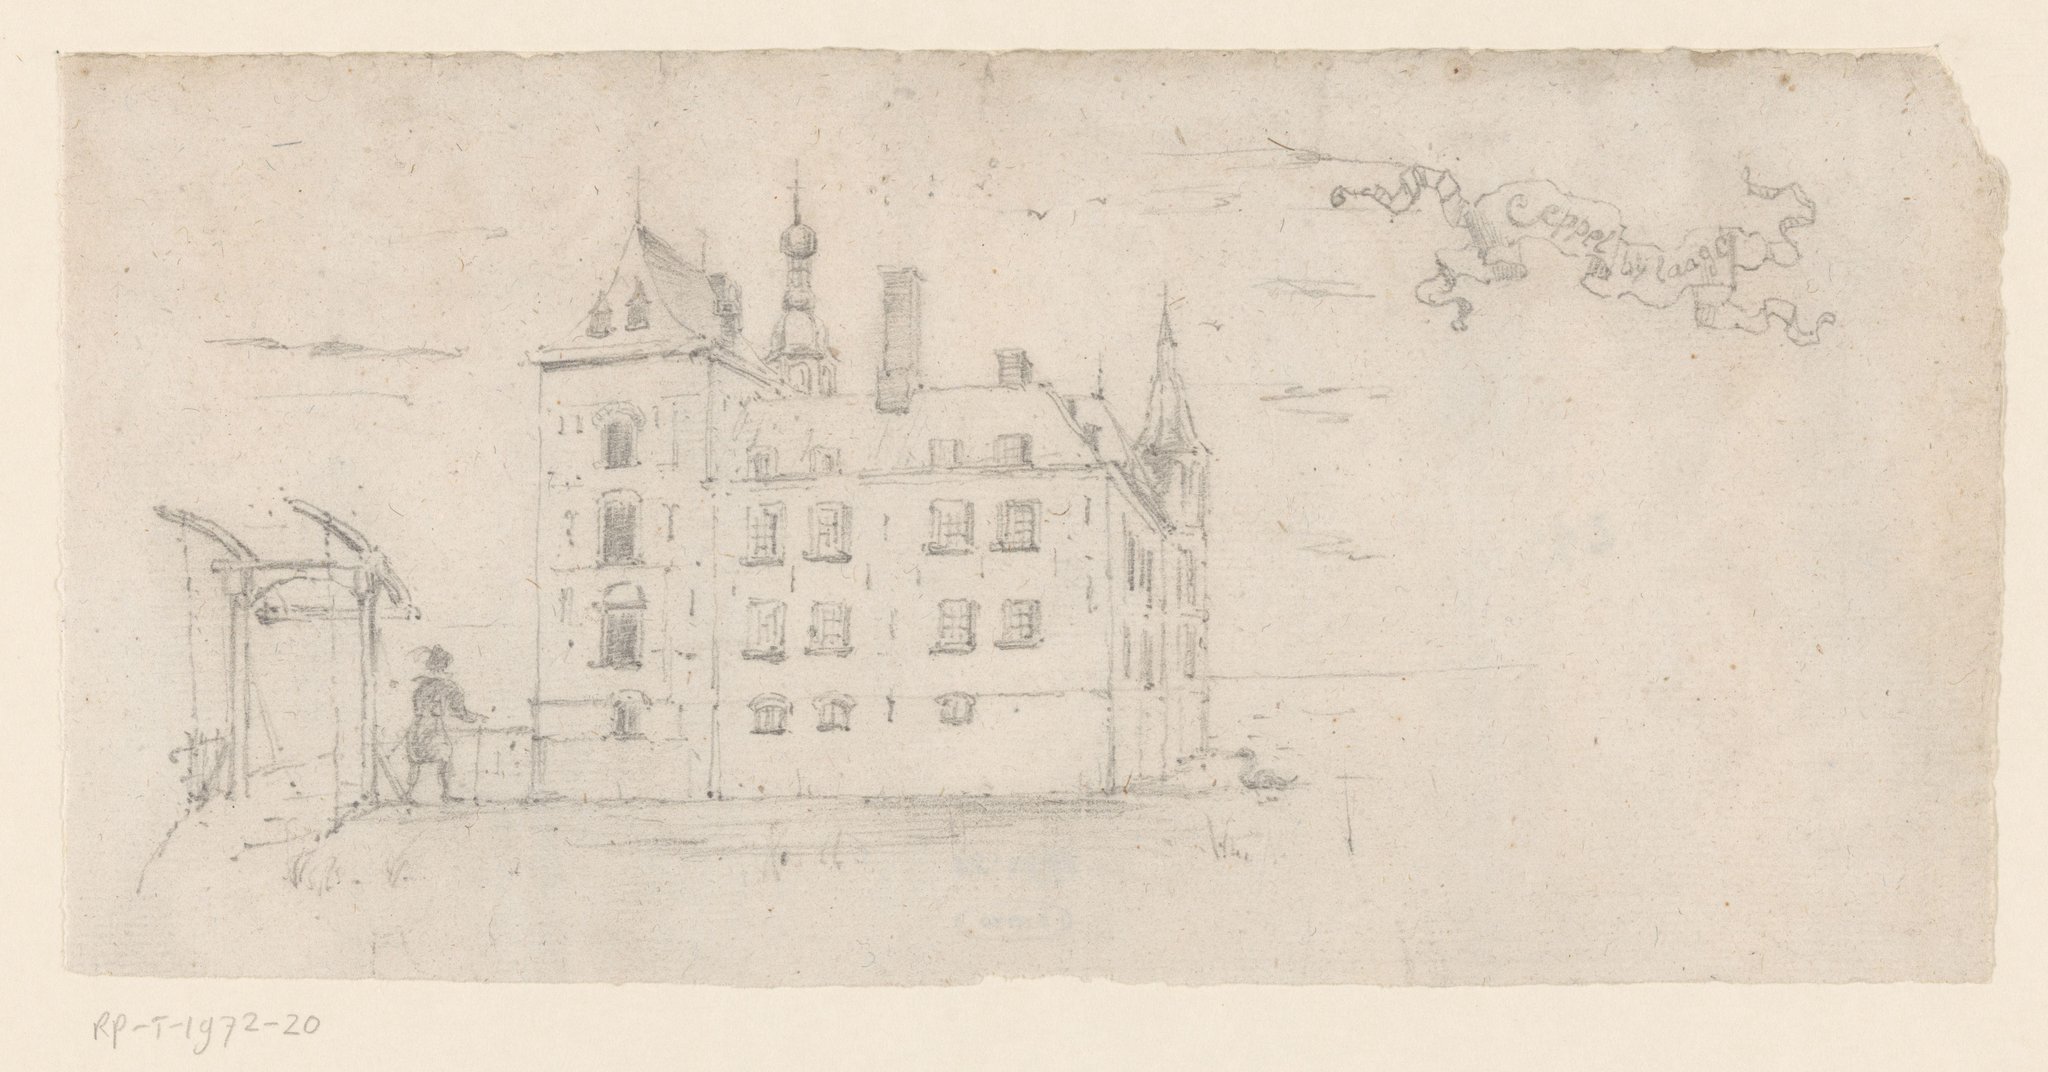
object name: drawing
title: Gezicht op Kasteel Keppel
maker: Anonymous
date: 1800-1850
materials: paper, pencil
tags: castle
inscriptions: collector's mark: Lugt 2228